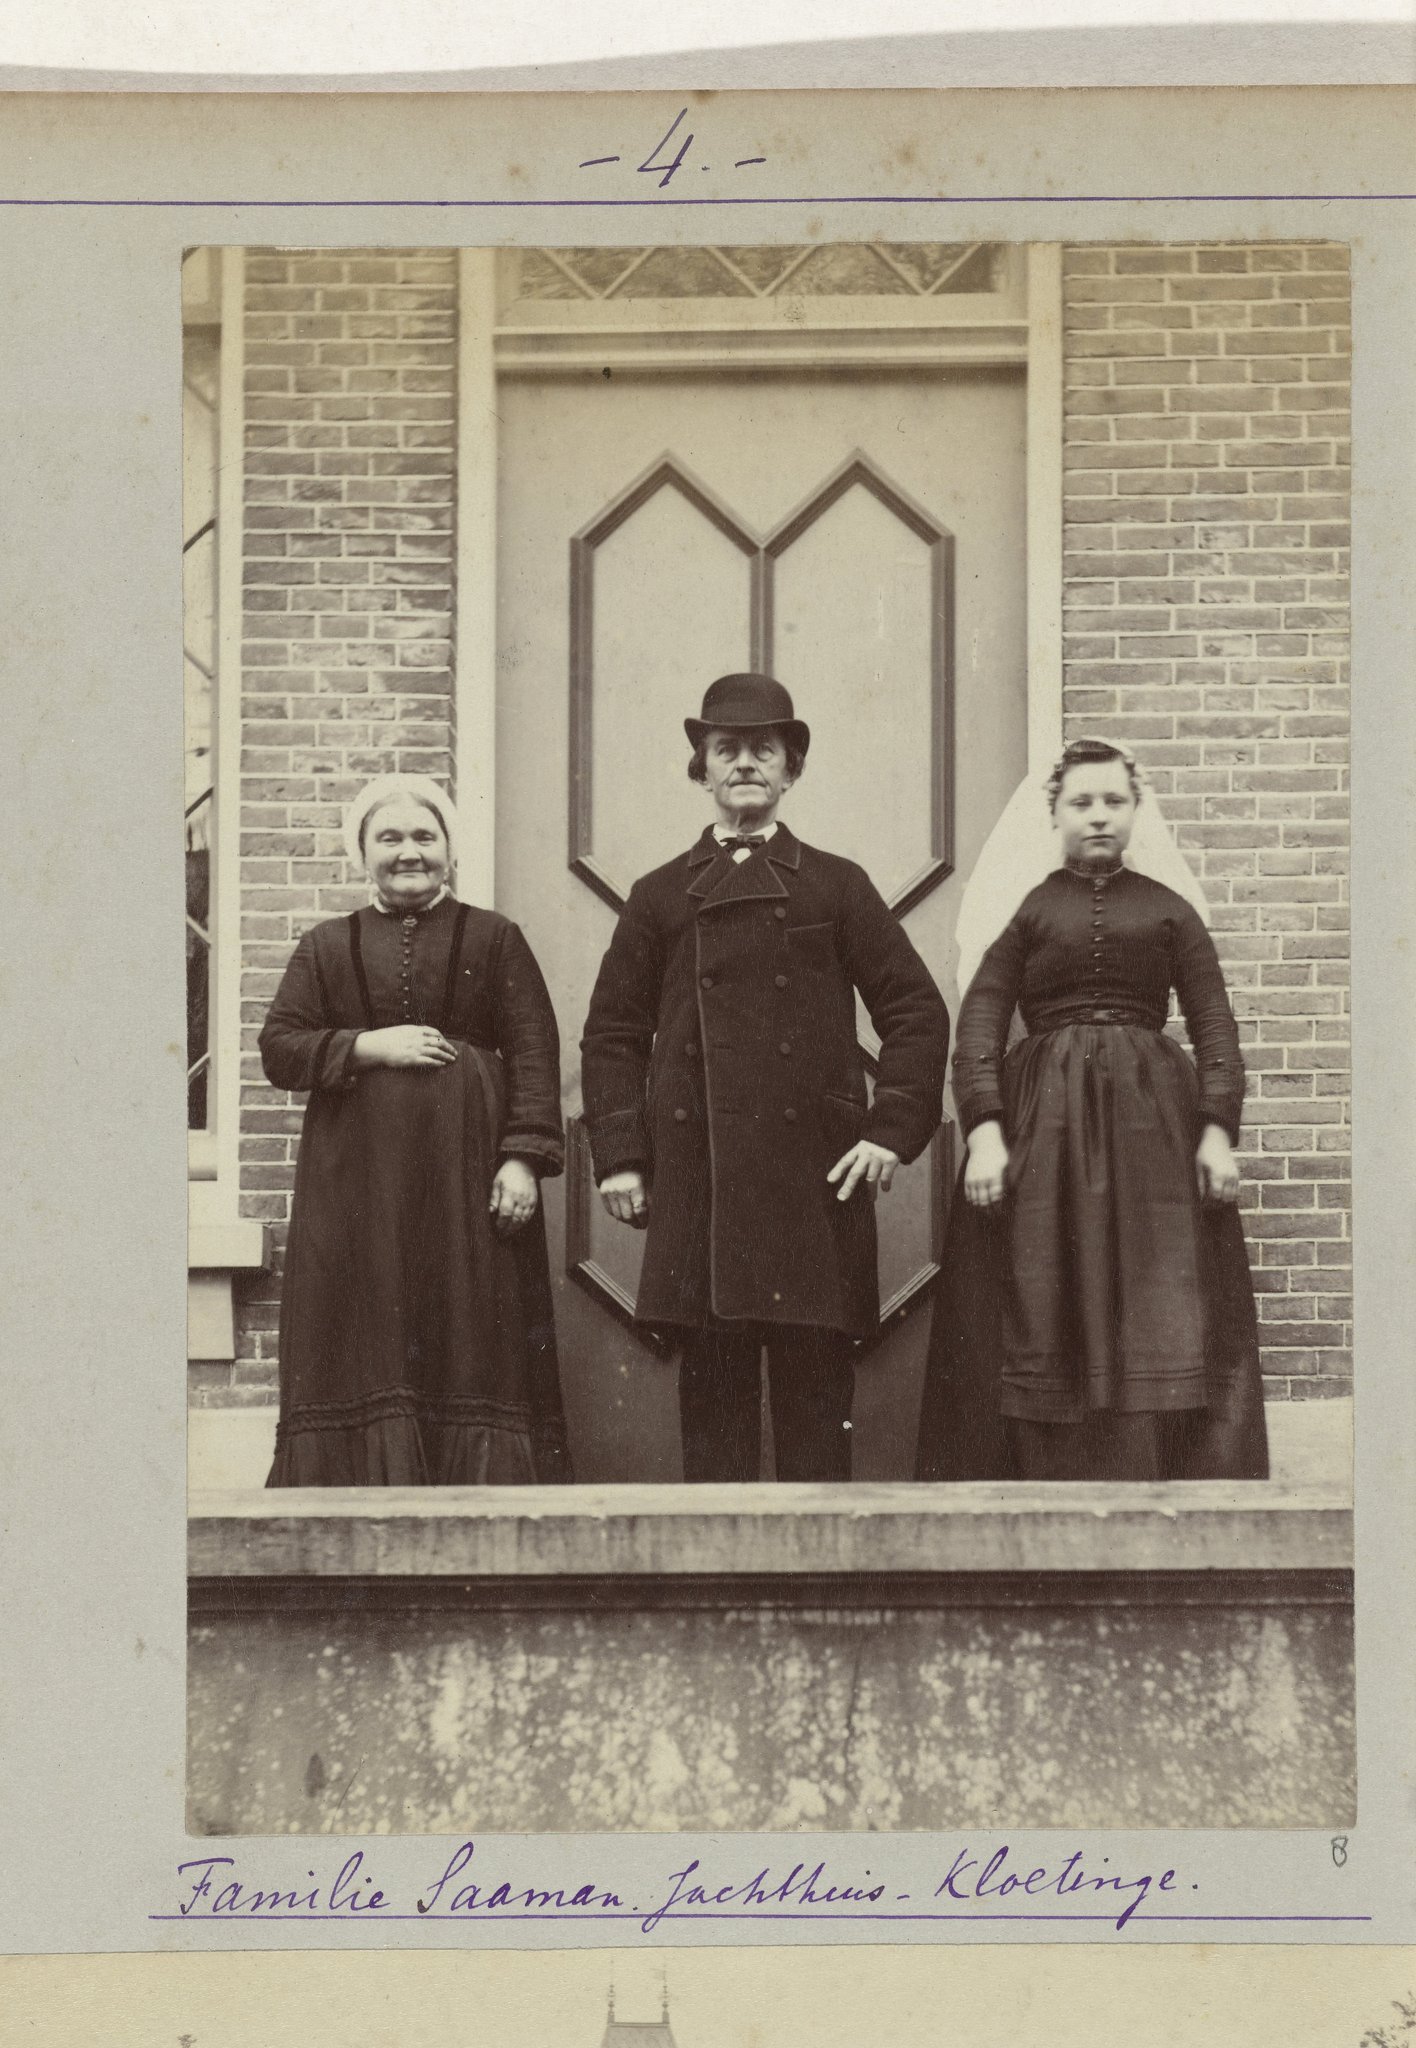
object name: photograph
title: Portret van de familie Saaman in Zeeuwse klederdracht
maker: henry pauw van wieldrecht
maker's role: fotograaf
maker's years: 1863-1912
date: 1888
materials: paper, photographic support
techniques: albumen print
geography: netherlands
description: De familie Saaman in Zeeuwse klederdracht. Met onderschrift: Familie Saaman, jachthuis Kloetinge.